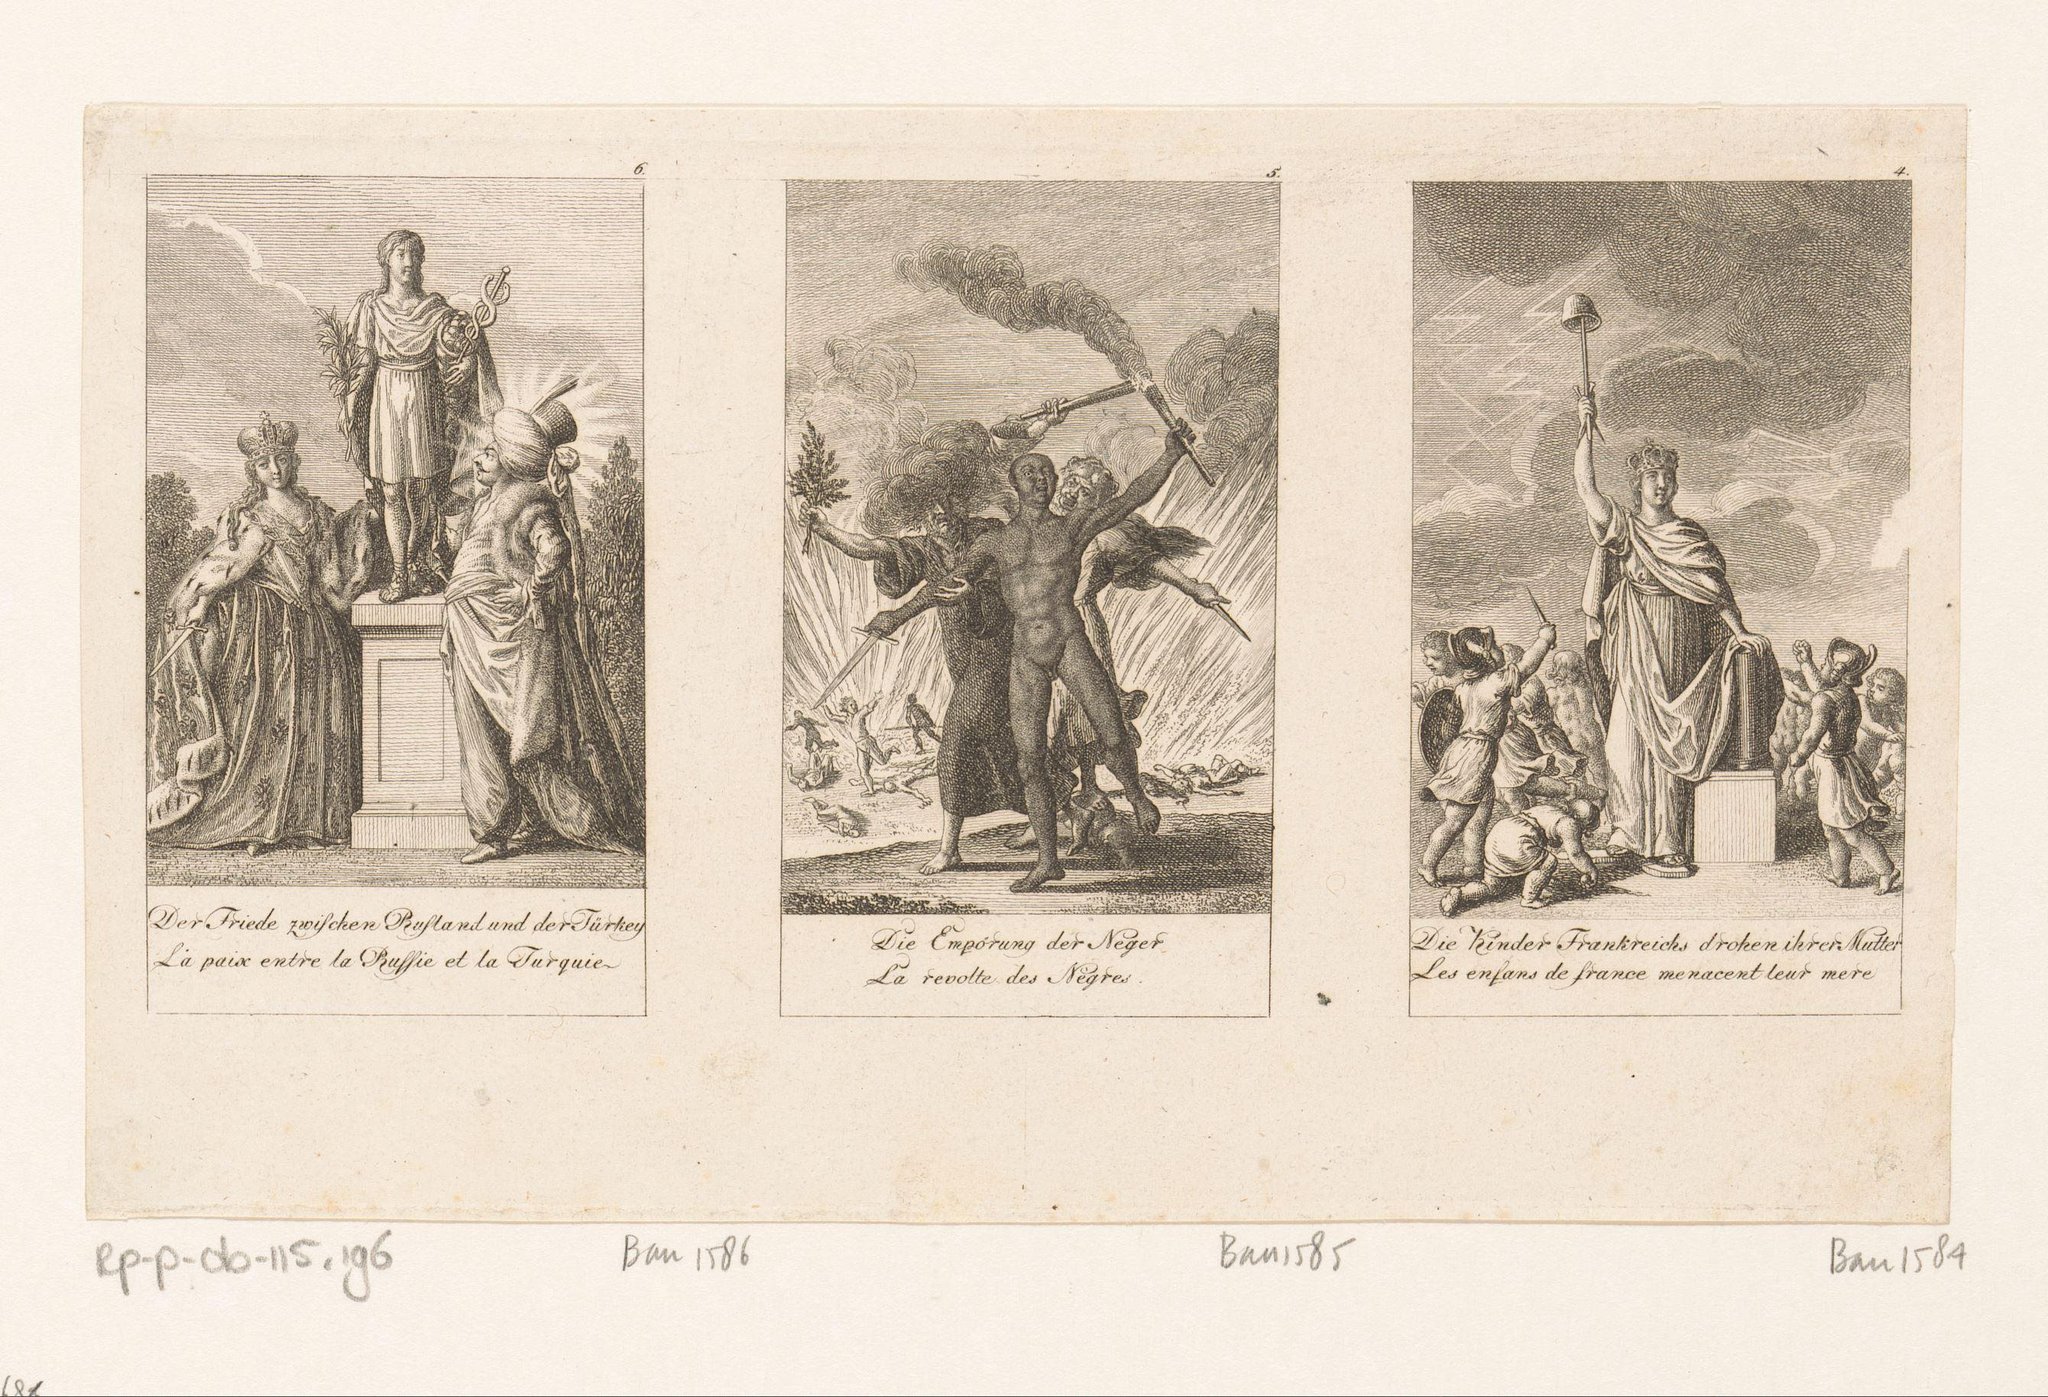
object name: print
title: Drie voorstellingen van gebeurtenissen uit de nieuwere geschiedenis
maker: daniel nikolaus chodowiecki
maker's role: draughtsman, print maker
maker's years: 1726-1801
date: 1792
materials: paper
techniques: etching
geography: berlin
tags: asiatic races and peoples: turks, history, africans, ruler, sovereign - bb - female ruler, despair; 'disperatione' (ripa), slavery; serfs and enslaved persons, monument, statue, lightning, flash of lightning, thunderbolt, revolution, revolt, phrygian bonnet, aesculapian sign, cruelty, ferocity; 'crudeltà', 'ferocità' (ripa), trees: olive-tree (+ branch, stick)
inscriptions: collector's mark: Lugt 2228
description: Prent gebruikt voor: Goettinger Taschen Calender für das Jahr 1793. Göttingen: Johann Christian Dietrich, [1792].